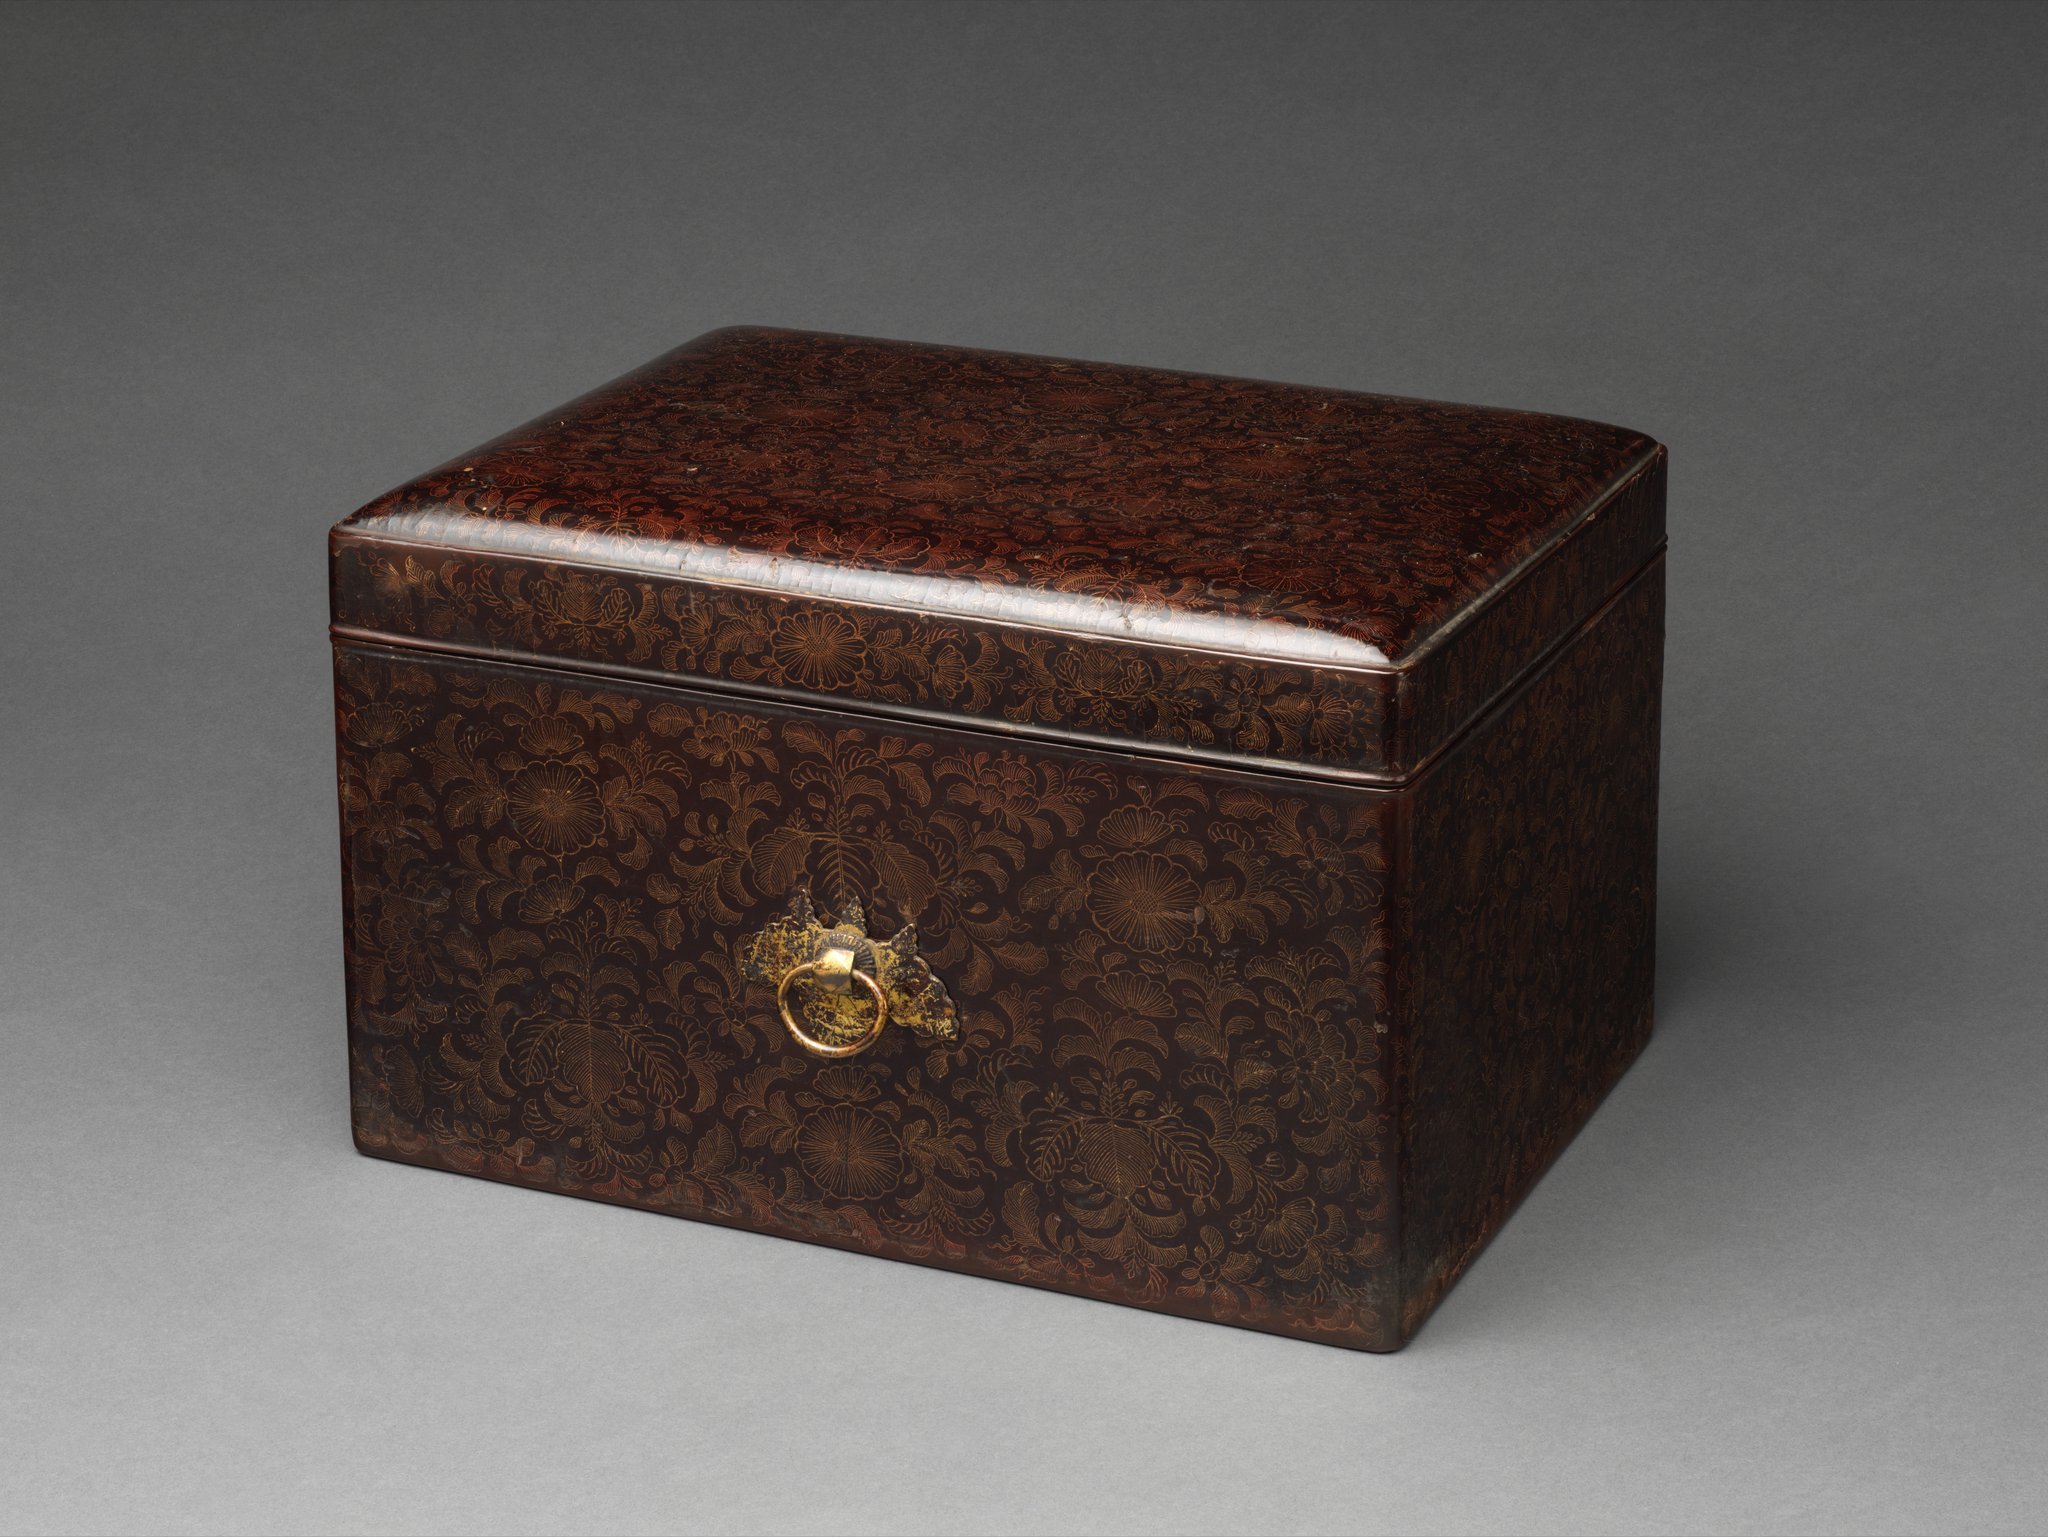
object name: box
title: Box for Personal Accessories (Tebako) with Chrysanthemums and Paulownia Flowers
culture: japanese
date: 1467-1500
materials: gilt bronze, gold, wood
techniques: incising, lacquer